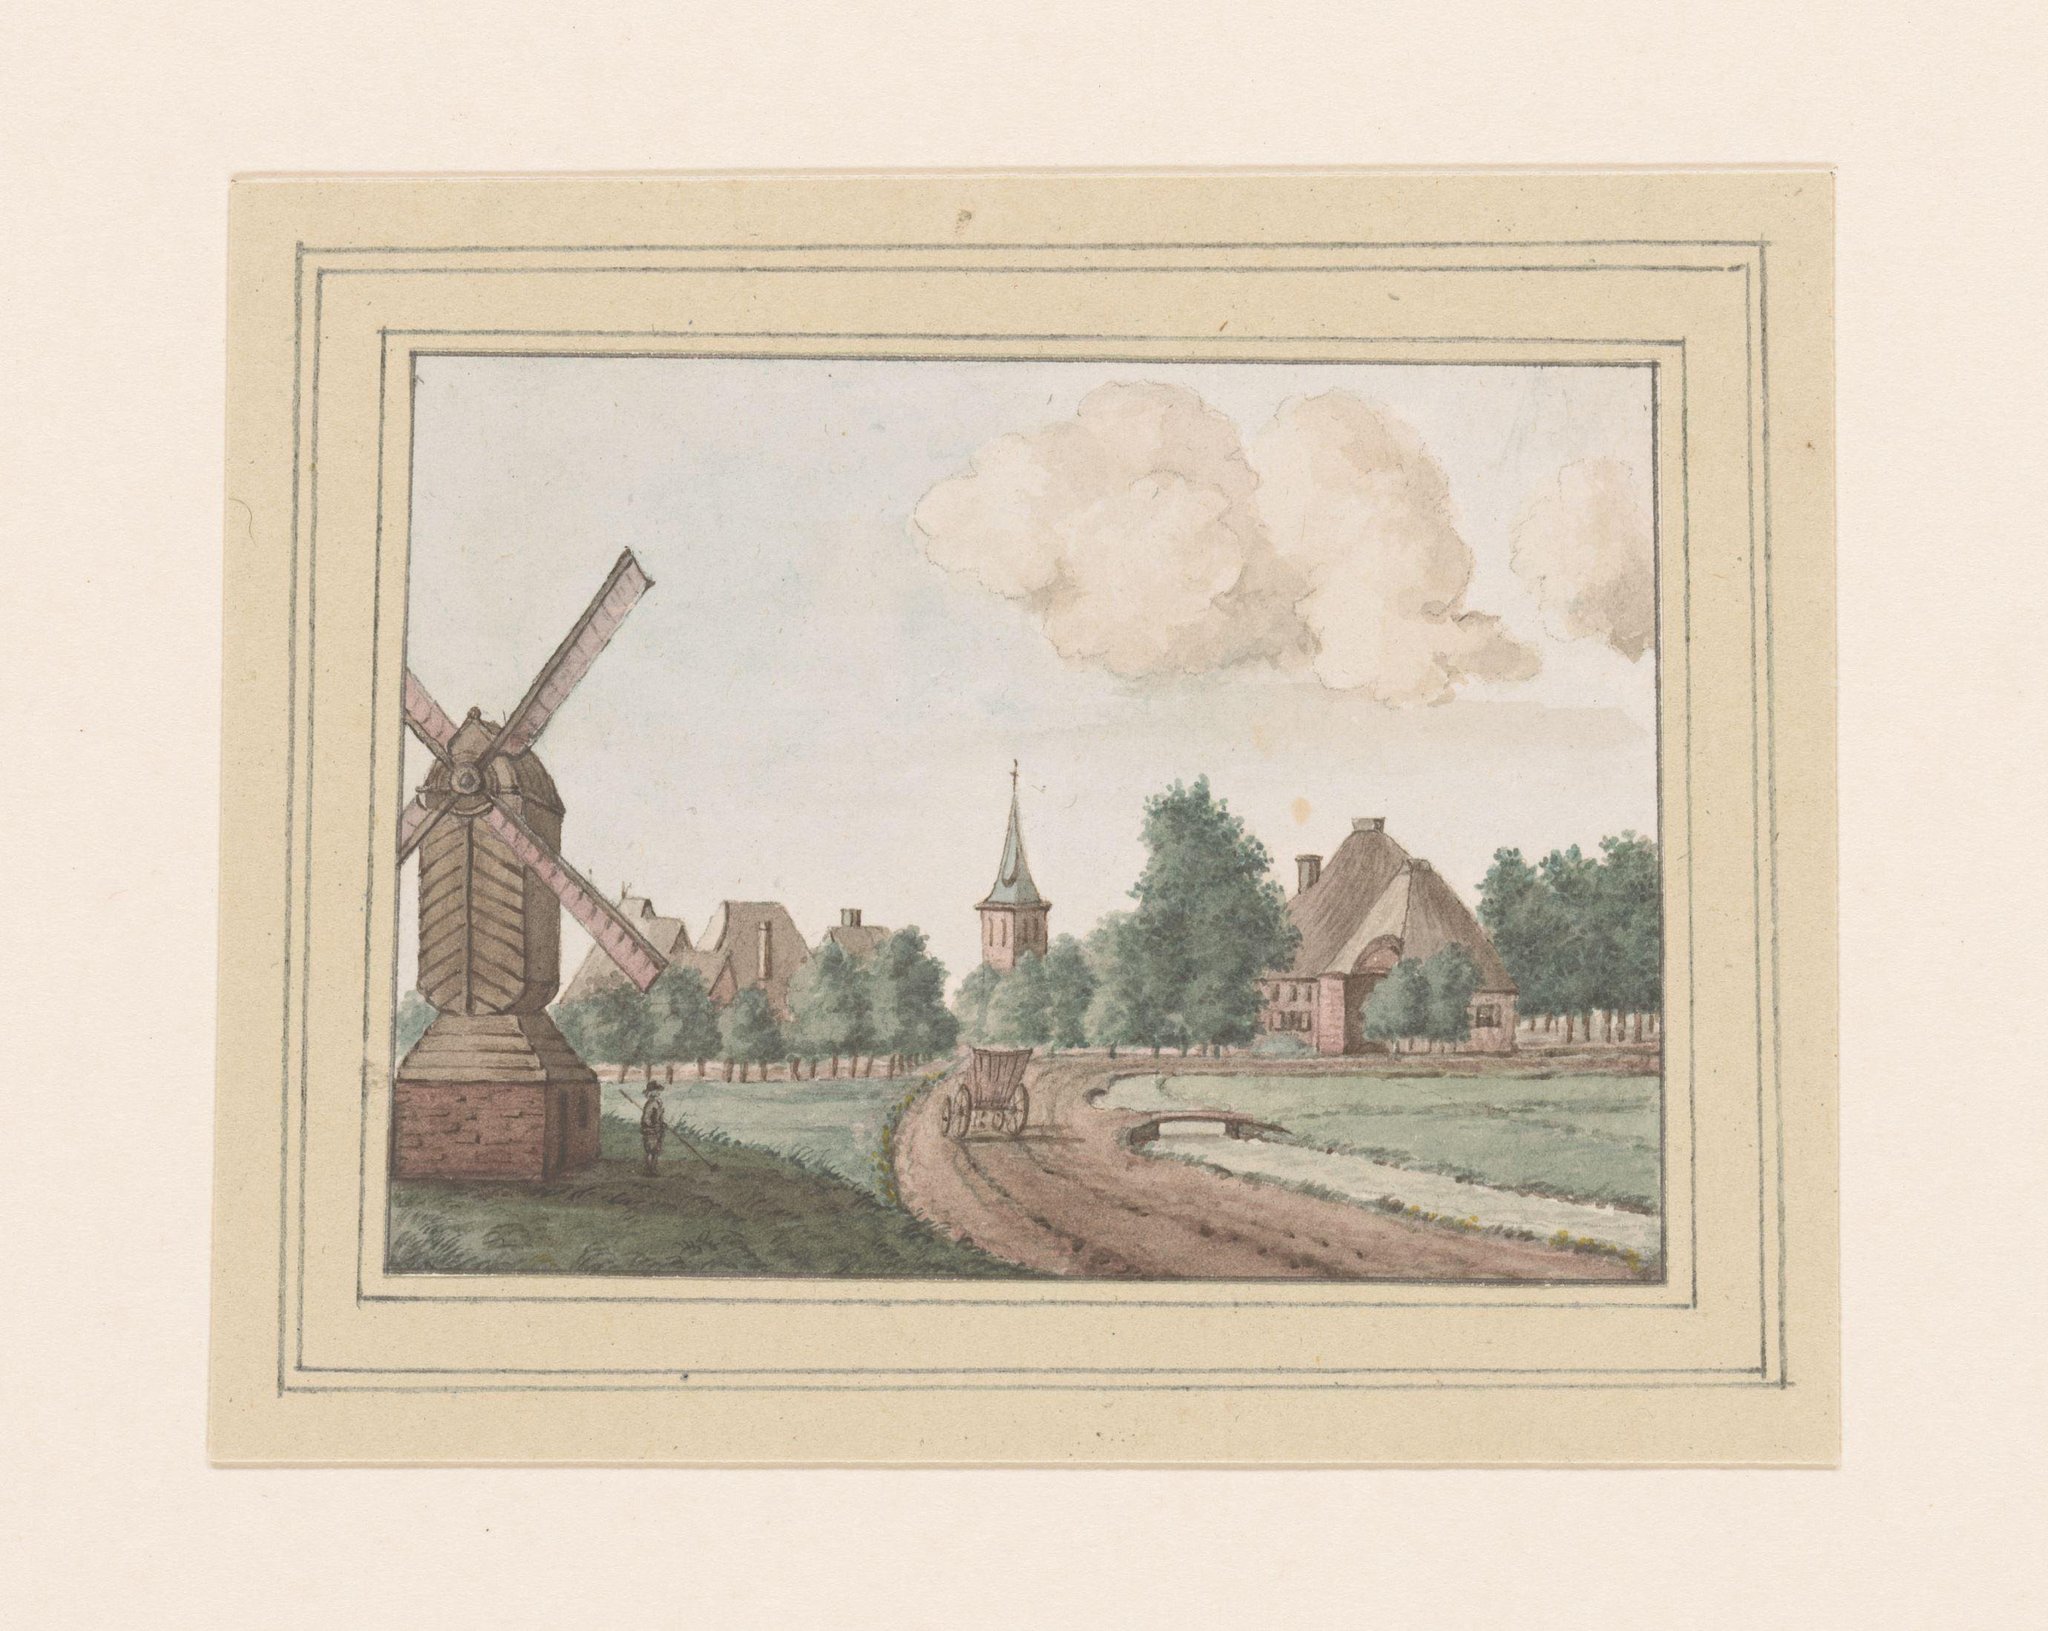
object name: drawing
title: Gezicht op Hauwert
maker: Anonymous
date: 1700-1800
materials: paper, pencil, watercolor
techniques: brush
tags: city-view, and landscape with man-made constructions, windmill in landscape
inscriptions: inscription: ‘'t Dorp Hauwert’